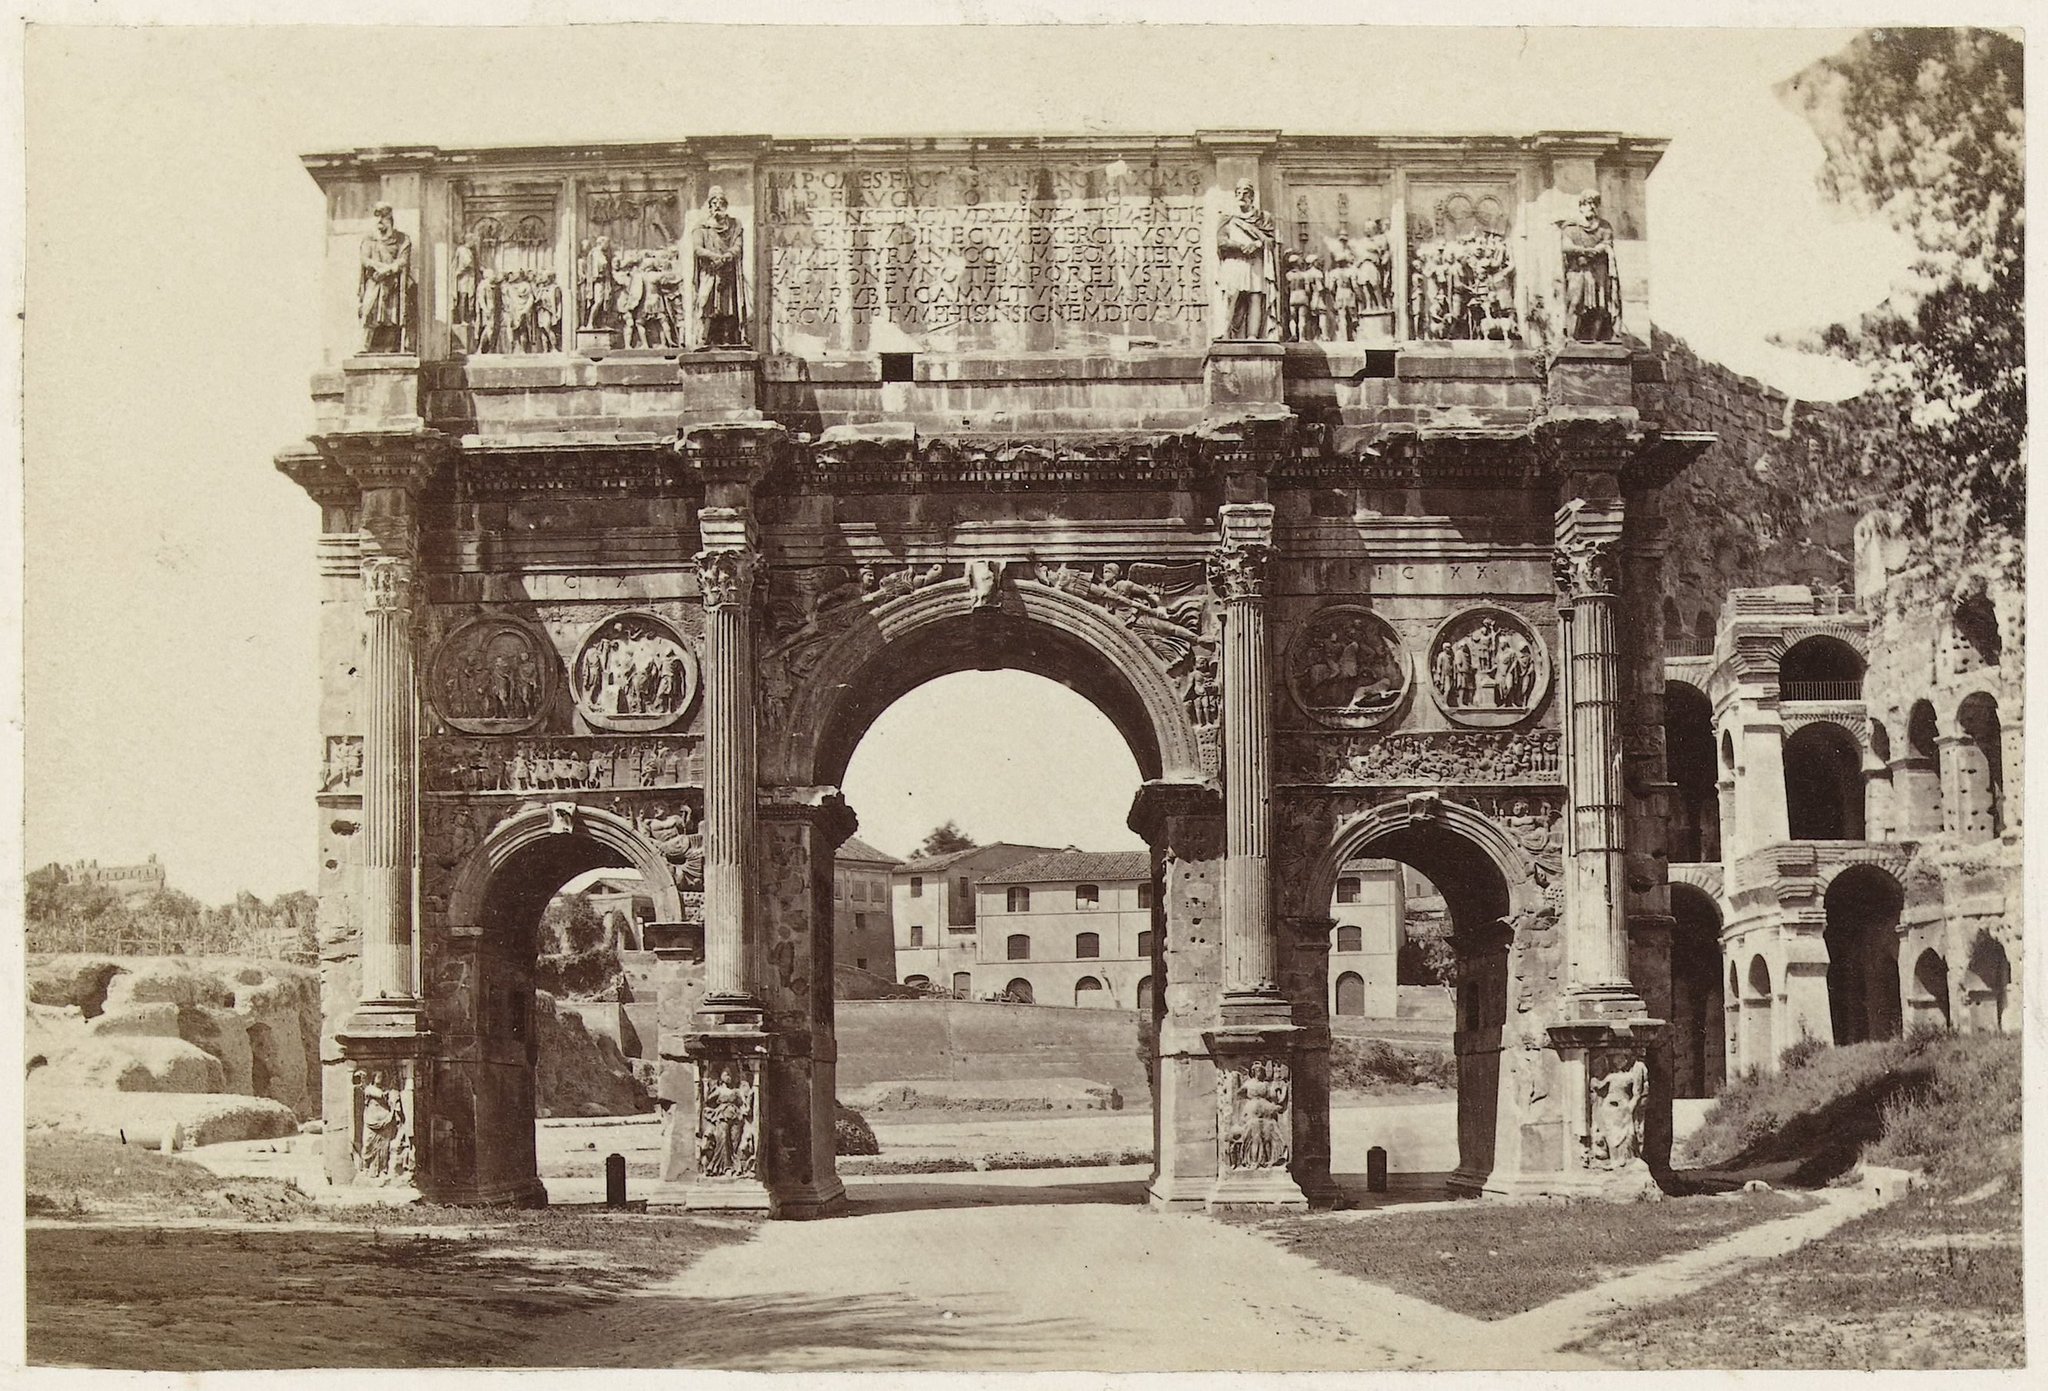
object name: photograph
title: Boog van Constantijn in Rome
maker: Anonymous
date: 1851-1900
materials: cardboard, paper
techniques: albumen print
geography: rome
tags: triumphal arch, arch of constantine